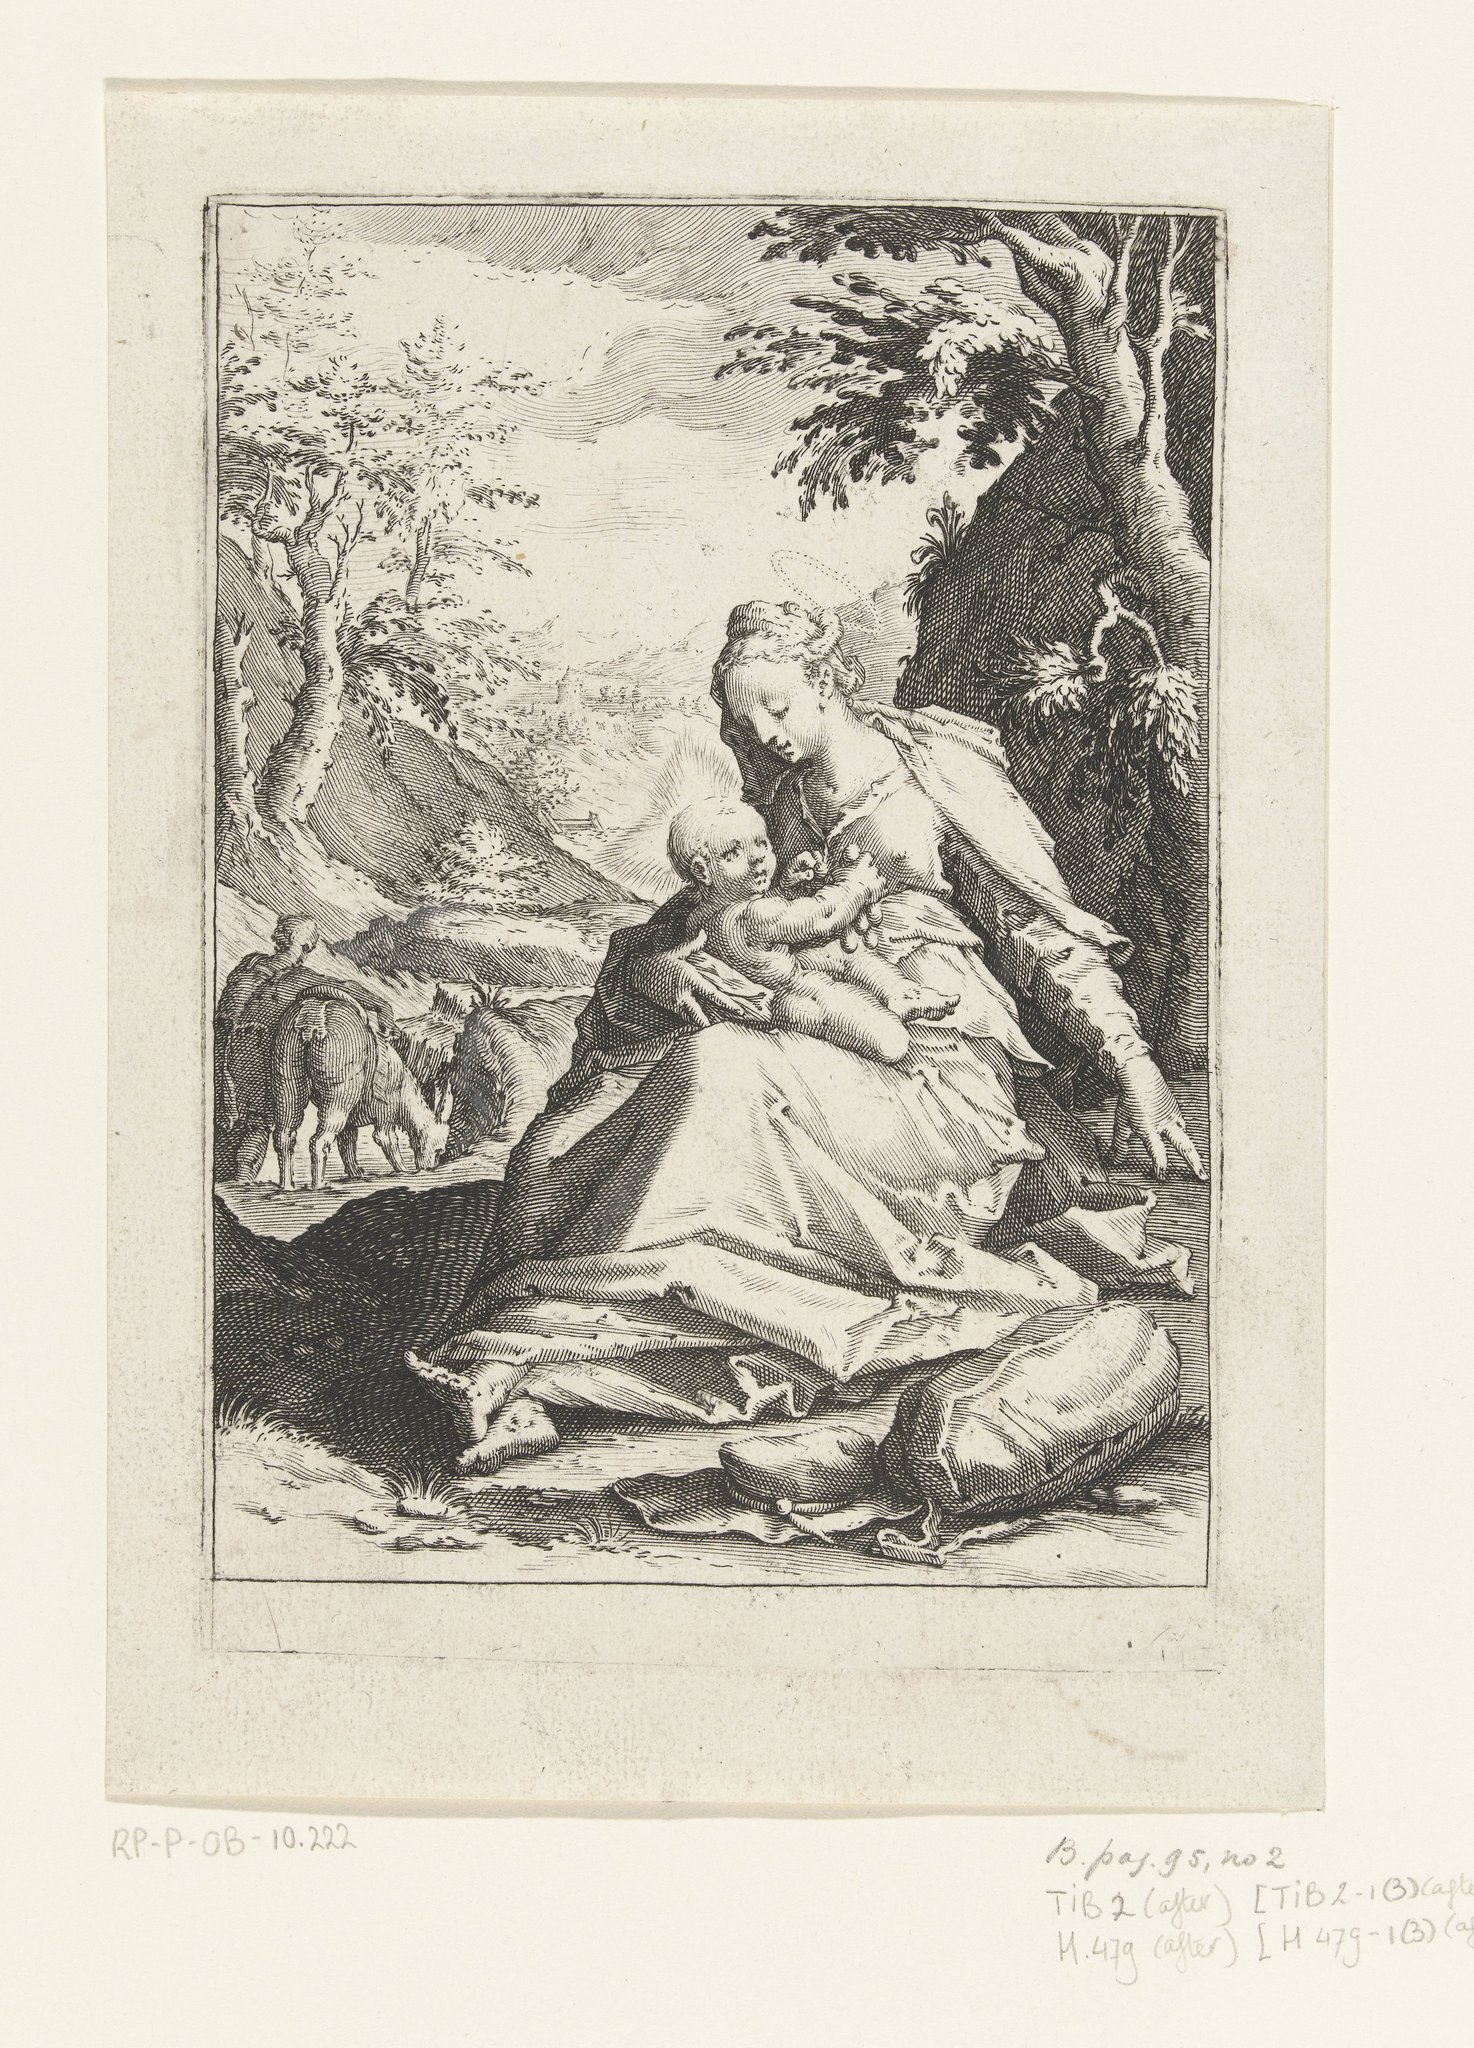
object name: print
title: Rest on the Flight into Egypt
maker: hendrick goltzius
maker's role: draughtsman, painter, print maker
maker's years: 1558-1617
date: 1587-1591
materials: paper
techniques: engraving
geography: haarlem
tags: rest on the flight into egypt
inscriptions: collector's mark: Lugt 240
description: Maria en het Christuskind rusten bij een boom in een bergachtig landschap. Op de achtergrond links Jozef met een ezel. Onder de voorstelling is ruimte leeg gelaten voor een onderschrift.